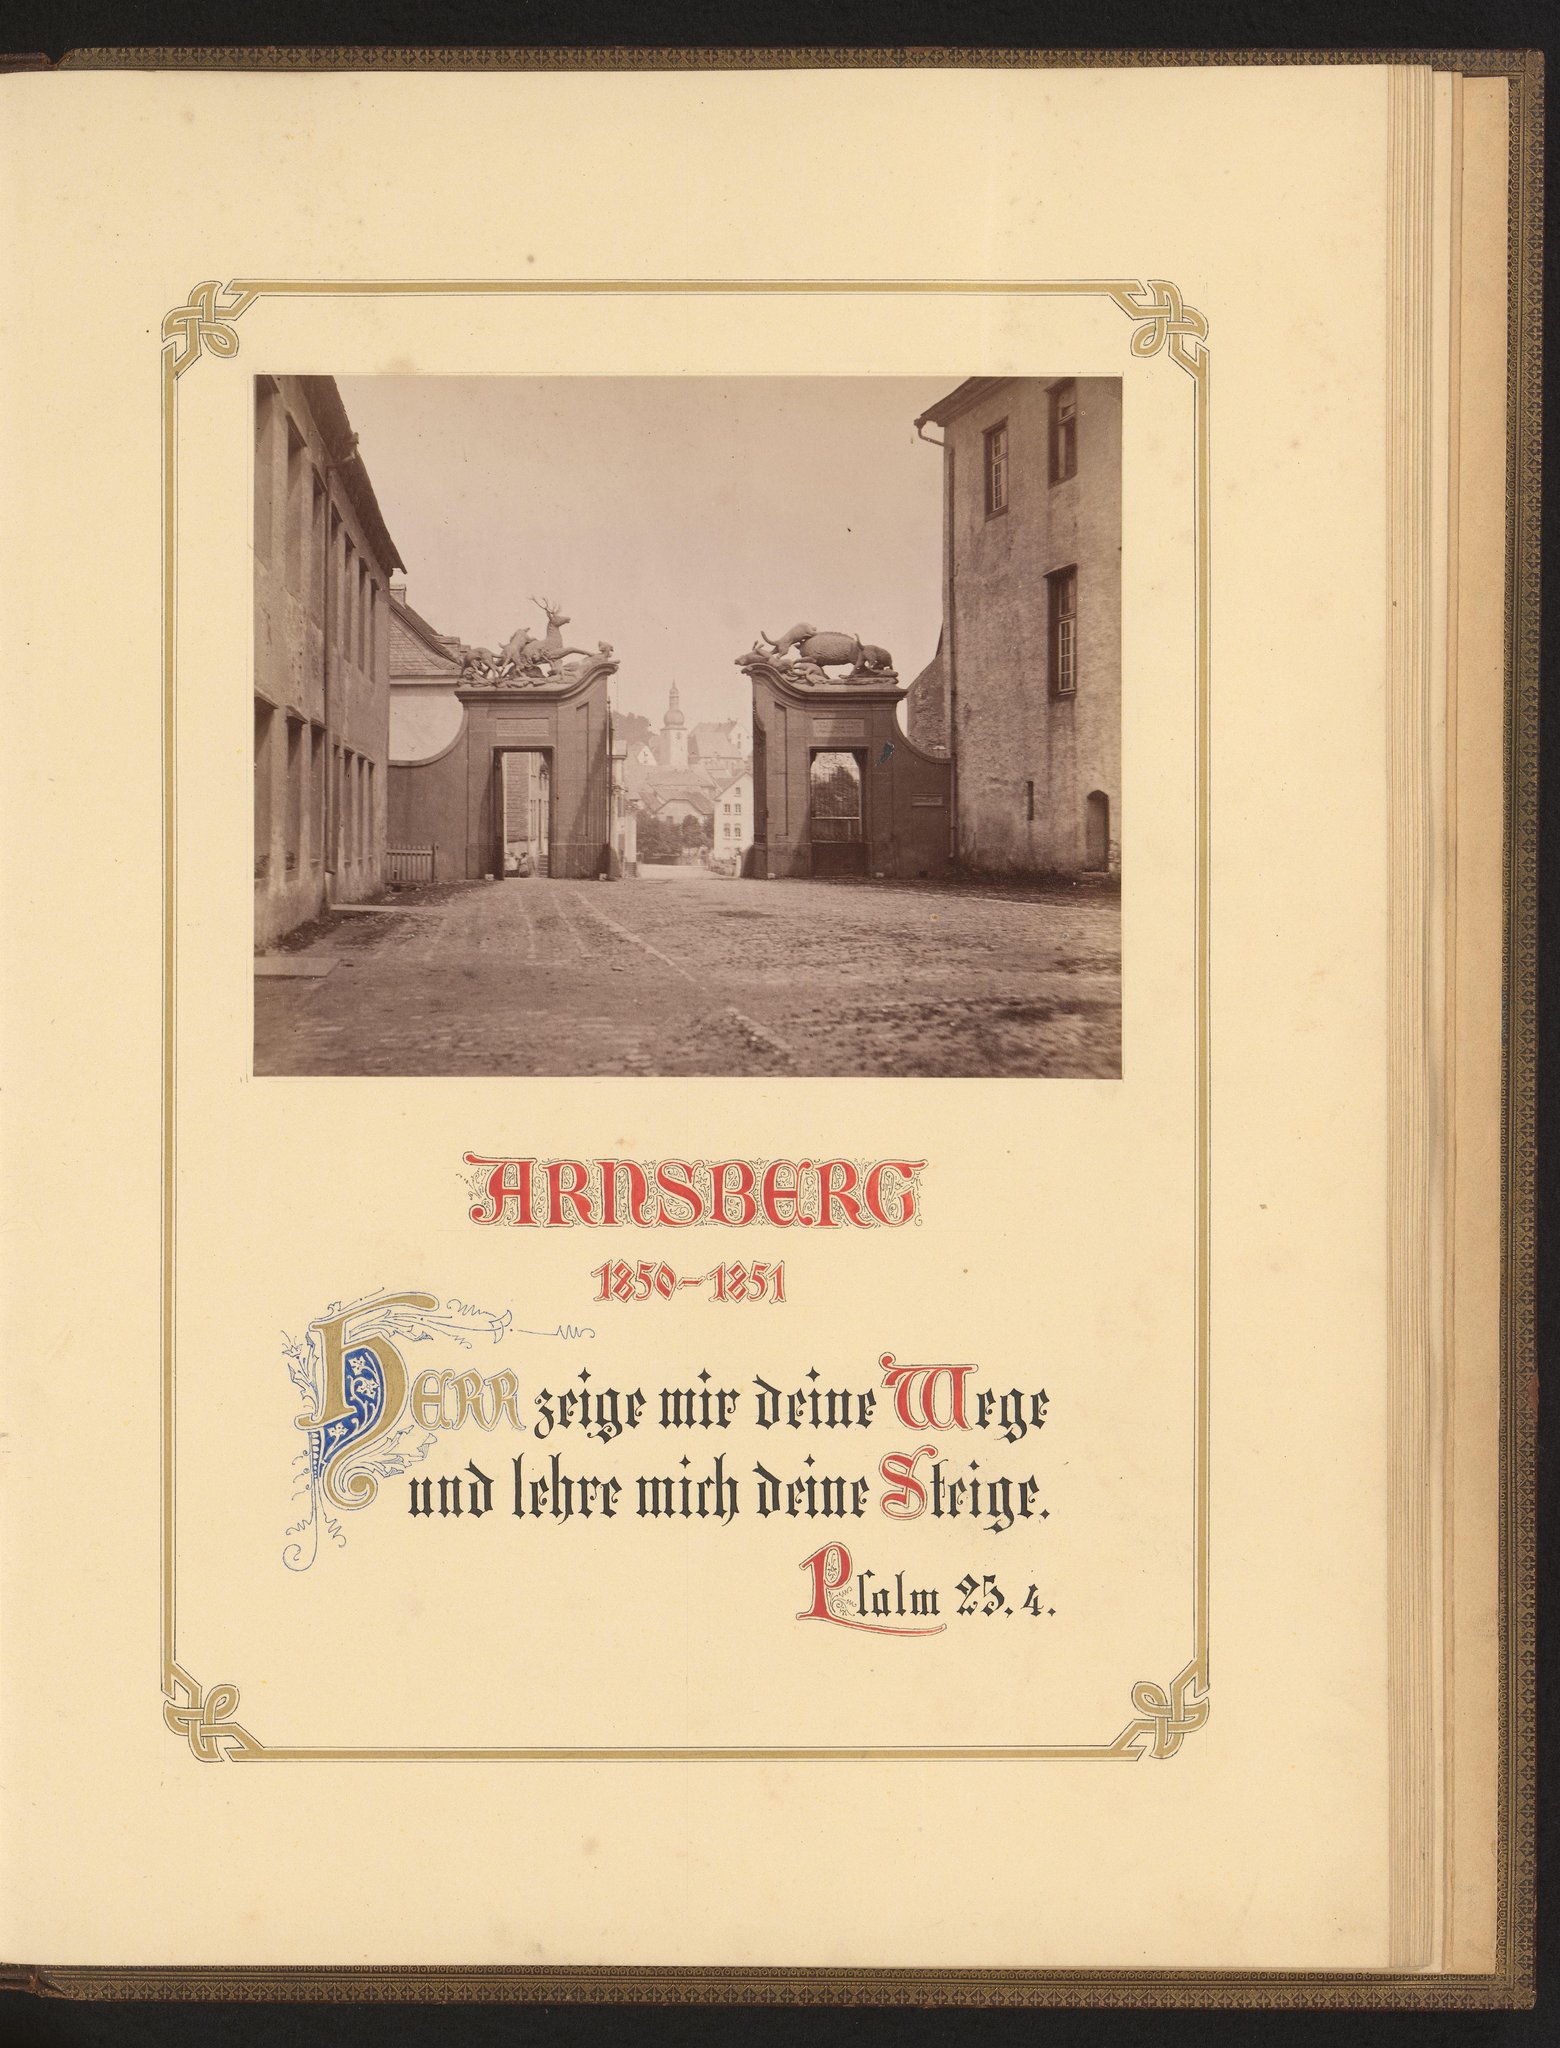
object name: album leaf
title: Hirschberger Tor met gezicht op Arnsberg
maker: Anonymous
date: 1873-1875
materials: paper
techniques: albumen print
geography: arnsberg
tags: city-view in general; 'veduta', gate, entrance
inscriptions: inscription: ‘Herr zeige mir deine Wege/ und lehre mich deine Steige./ Psalm 25,4.’